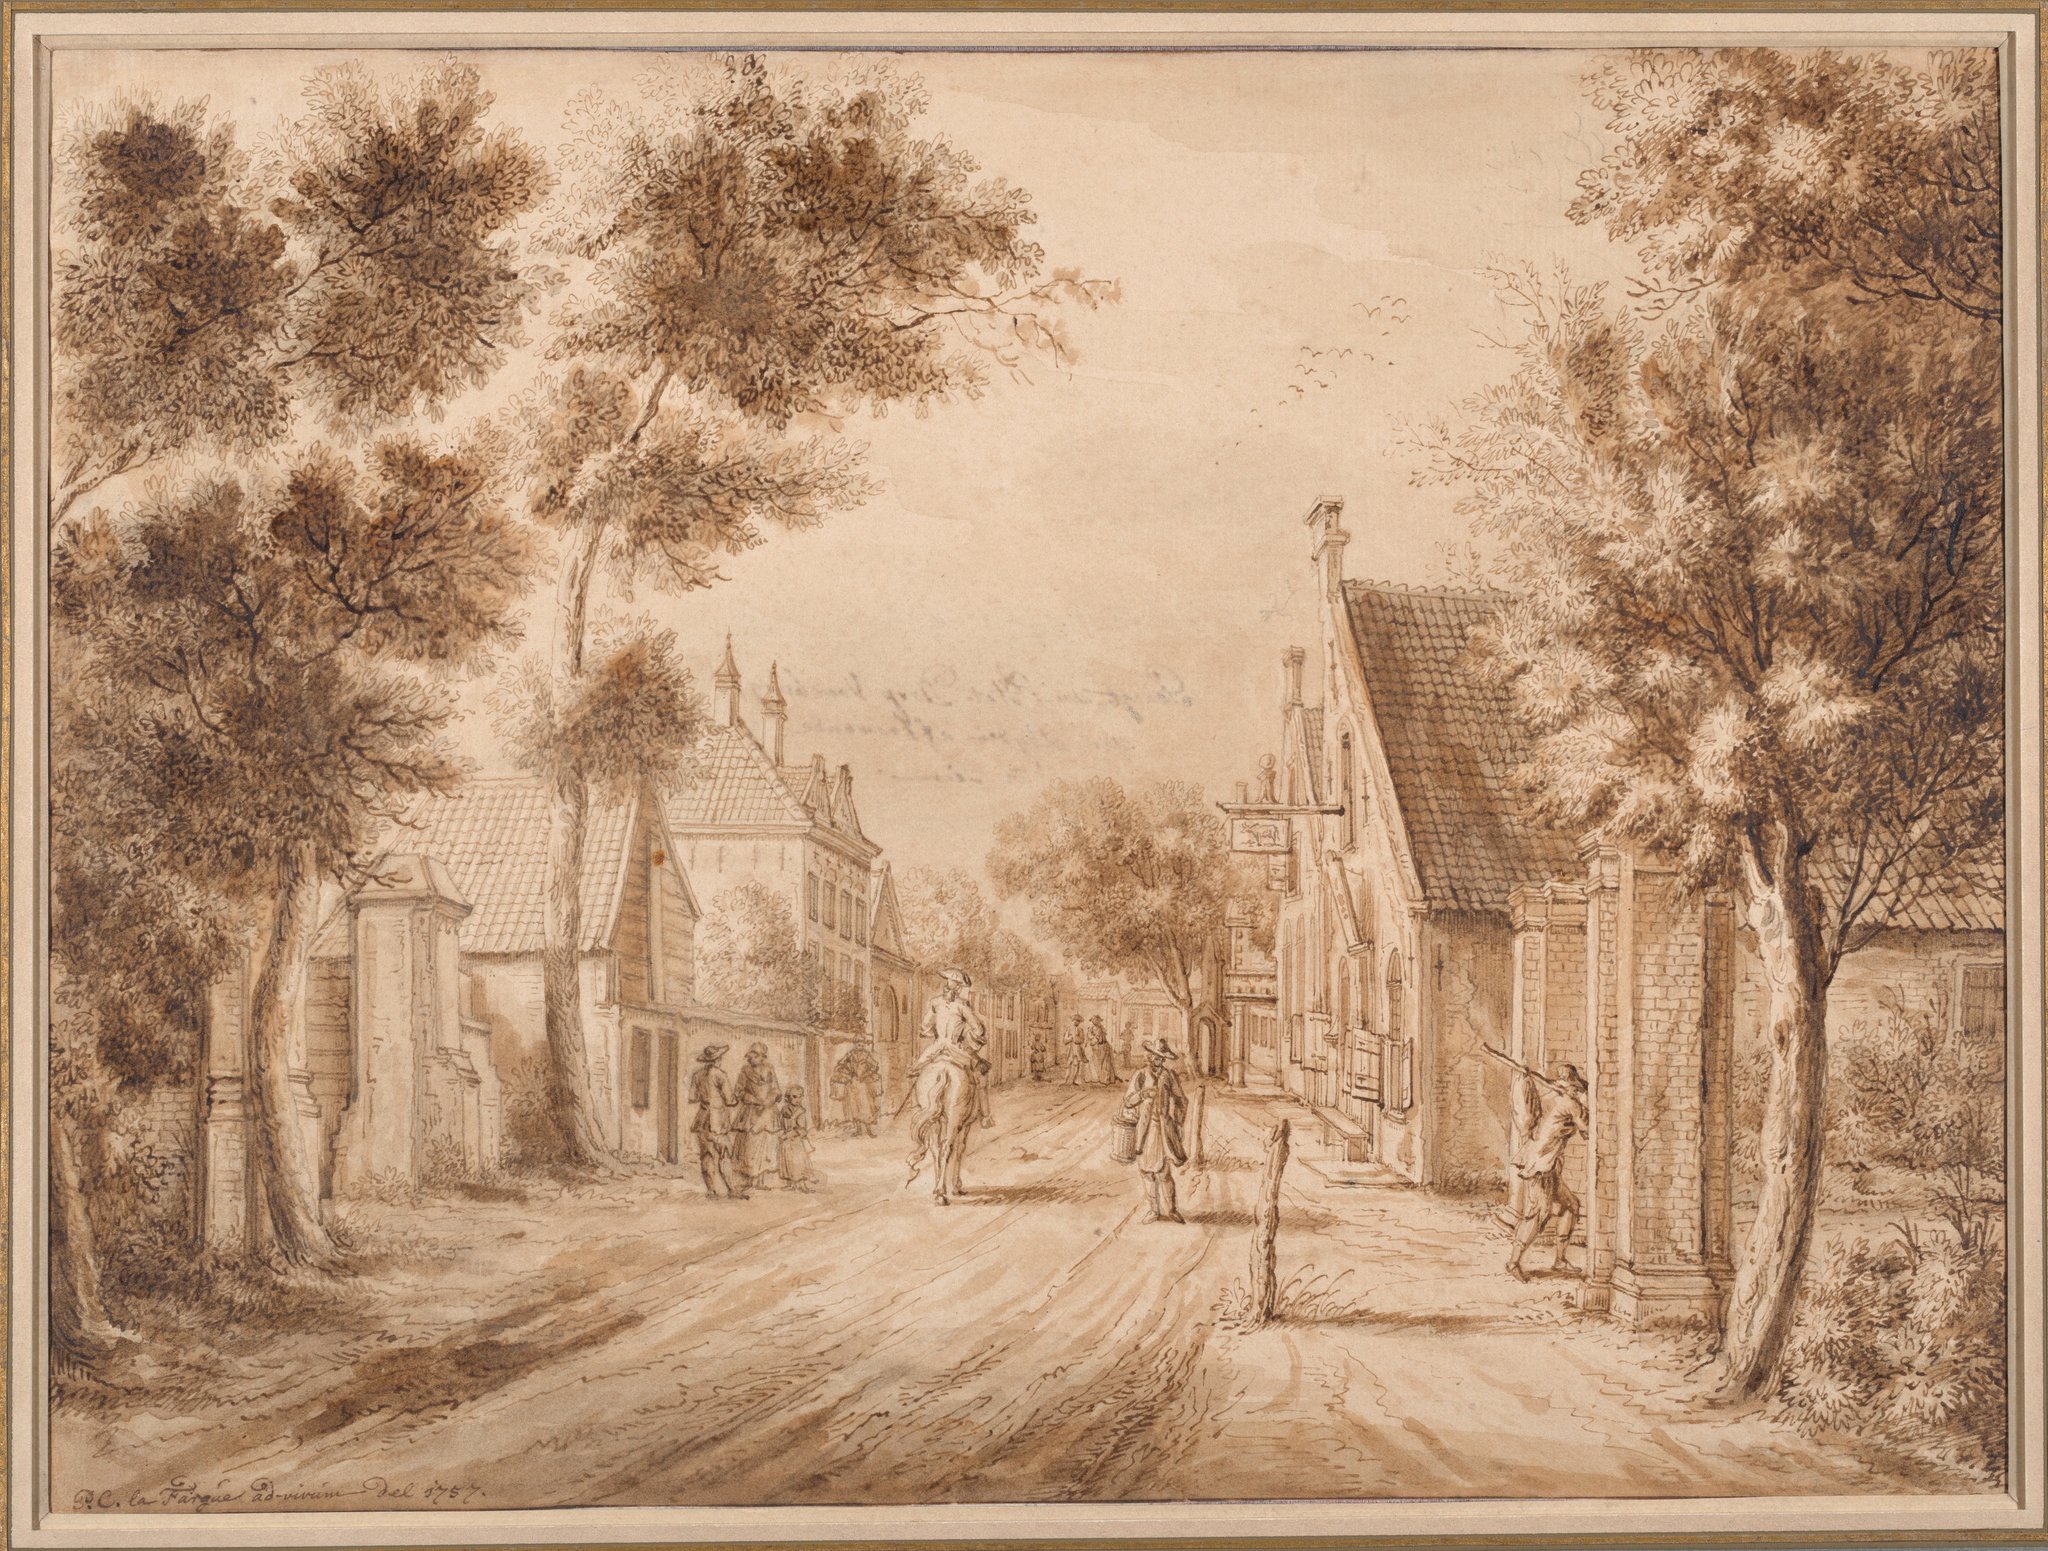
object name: drawing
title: A View of the Herenstraat in Voorburg, Seen from the Oosteinde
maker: paulus constantijn la fargue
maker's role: artist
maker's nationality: dutch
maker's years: 1729-1782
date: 1757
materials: graphite, ink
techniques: brush, pen, wash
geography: netherlands